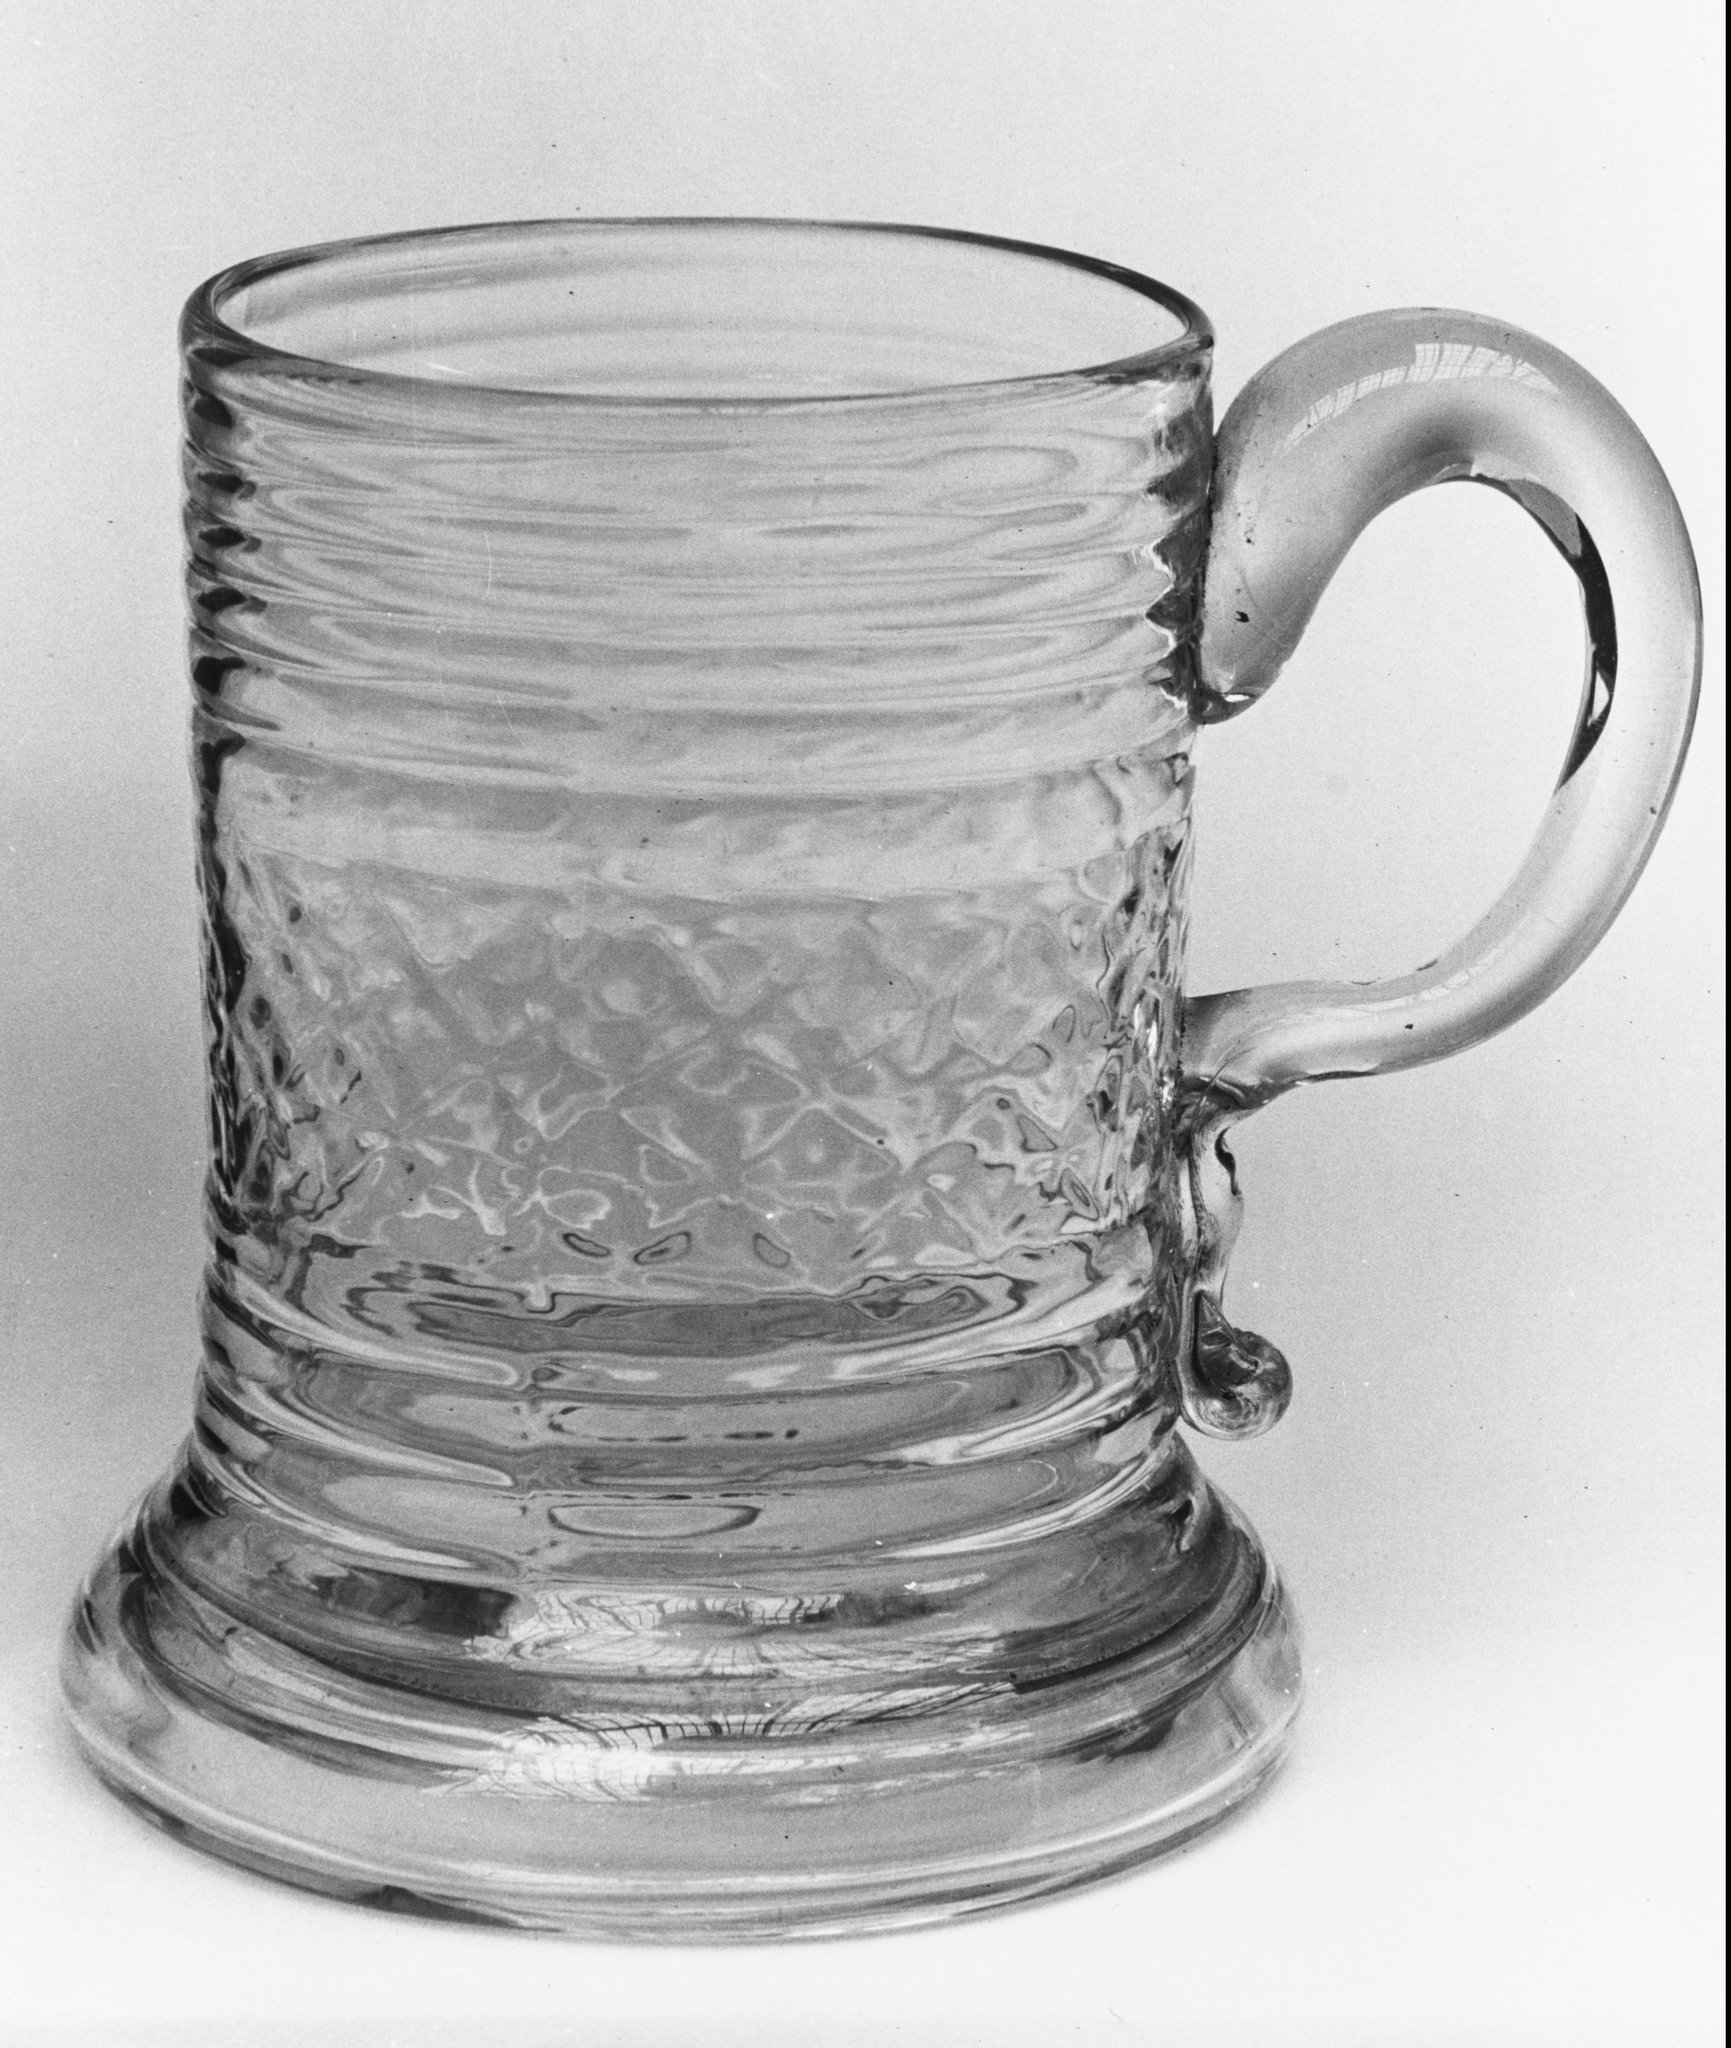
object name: mug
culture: american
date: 1820-1840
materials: glass, lead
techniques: glassblowing, molding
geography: united states